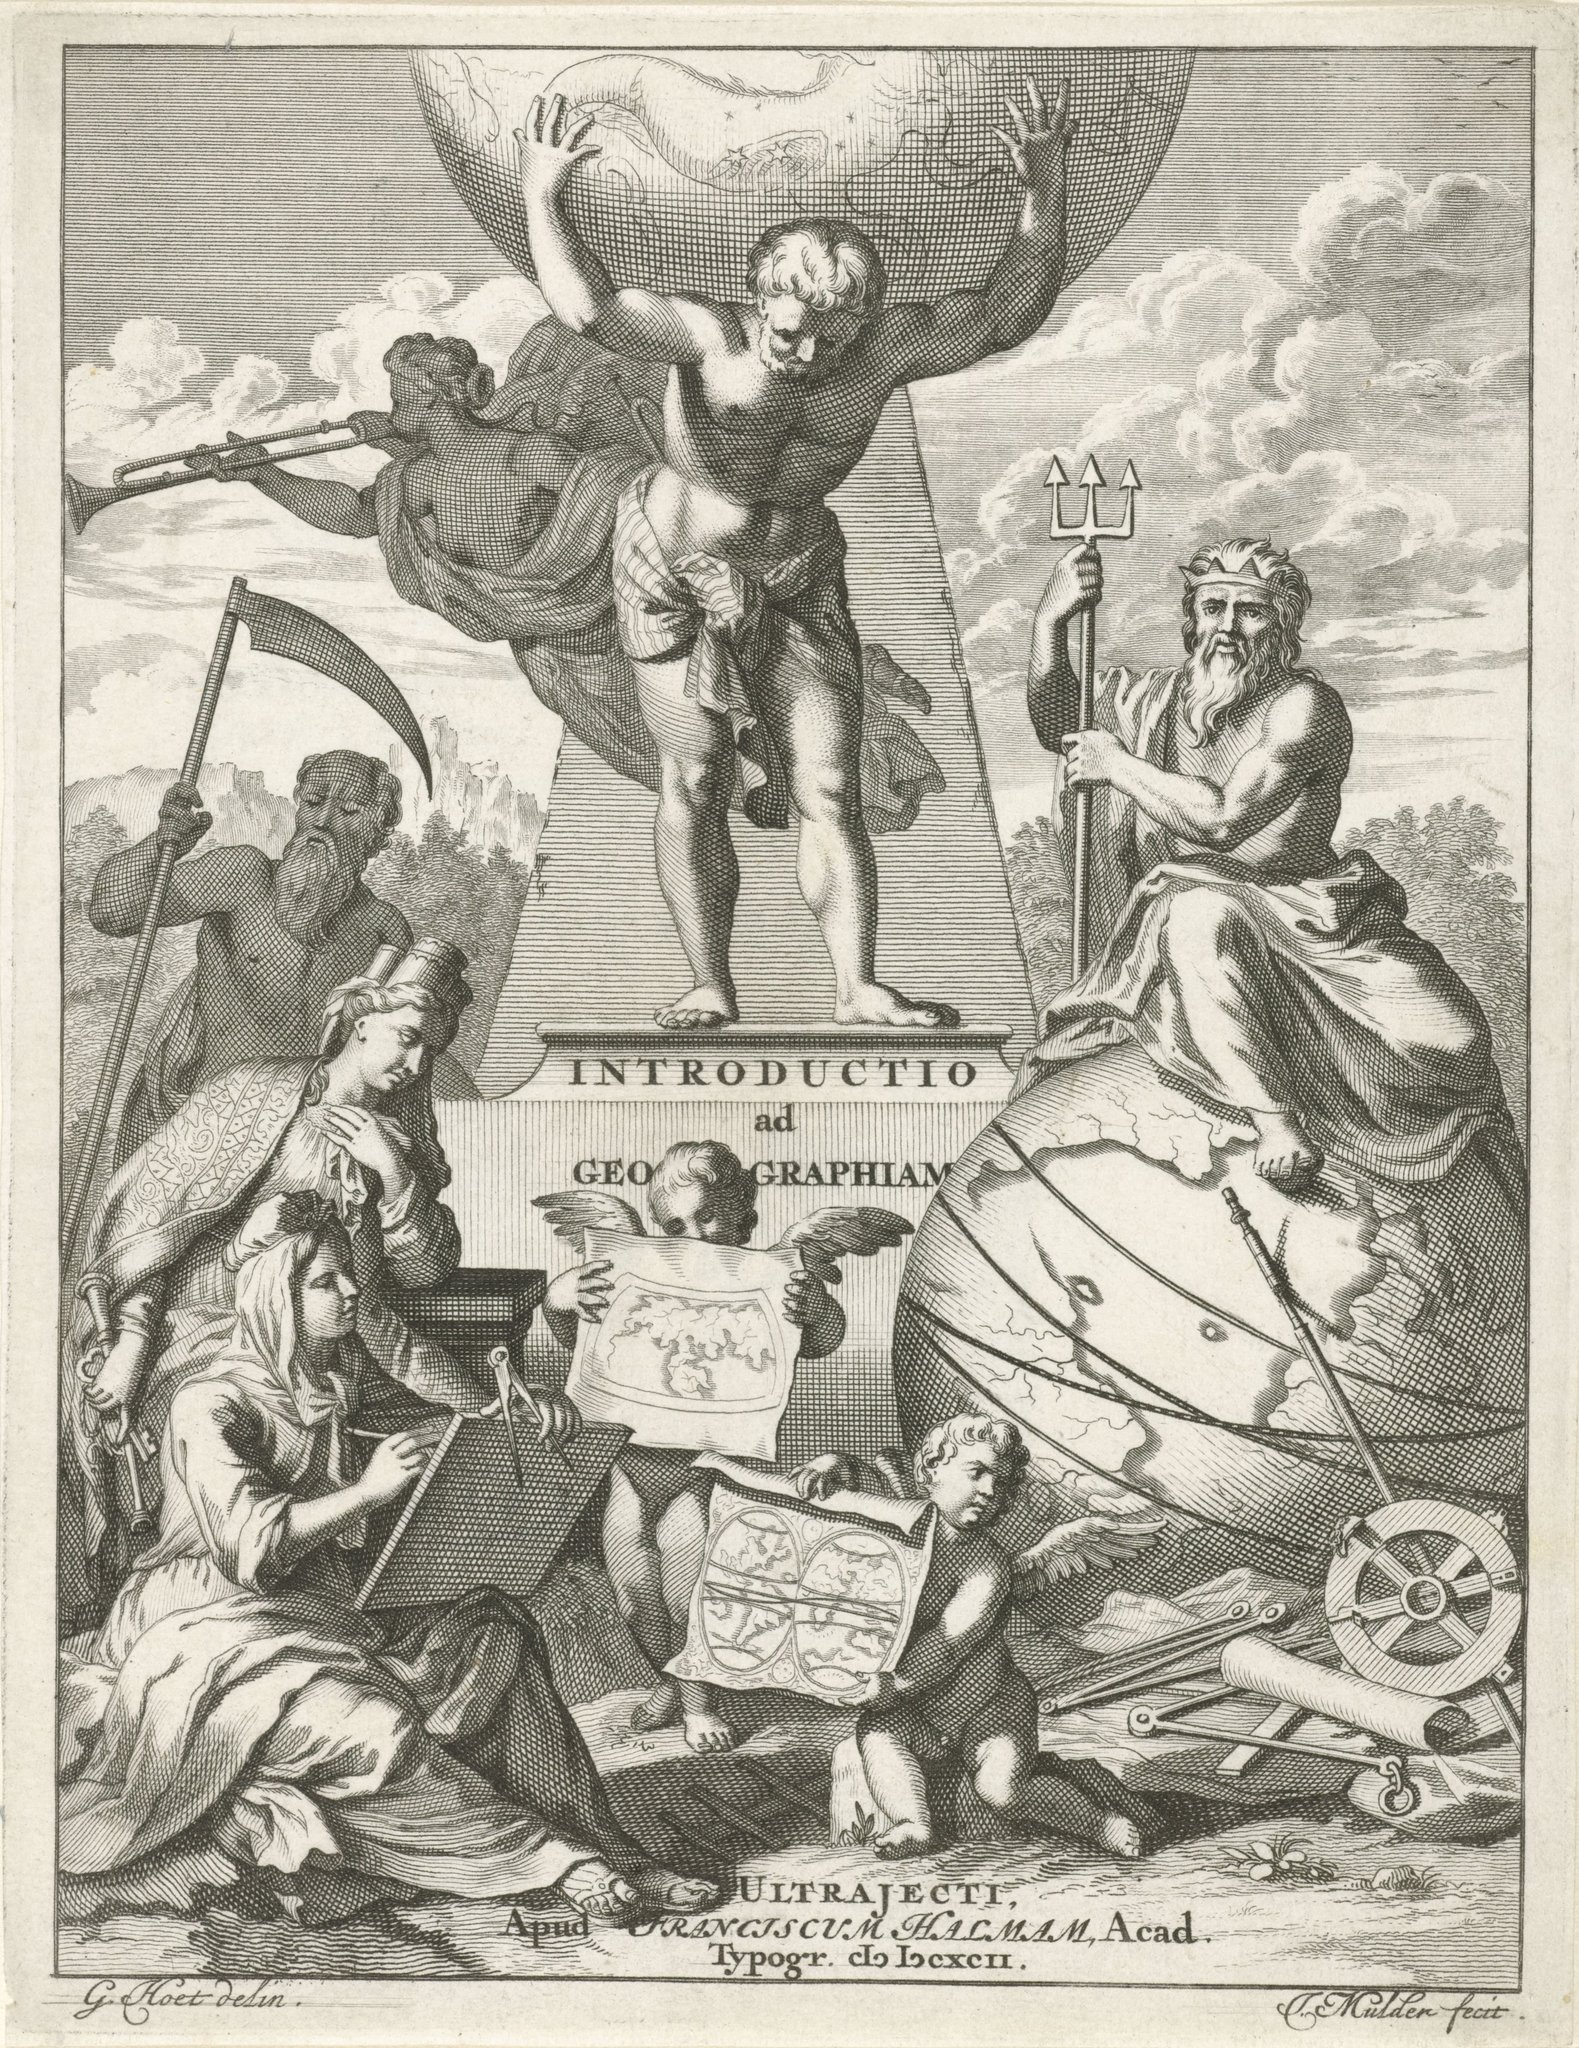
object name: print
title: Titelpagina voor: J. Luyts, Introductio ad geographiam novam et veterem, 1692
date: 1692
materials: paper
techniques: engraving, etching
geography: amsterdam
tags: (story of) neptune (poseidon), father time, man with wings and scythe (+ variant), (story of) cybele, rhea cybele, great mother of the gods (berecynt(h)ia), (story of) atlas, maps, atlases, compasses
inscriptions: collector's mark: Lugt 2228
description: In het midden torst Atlas de wereld op zijn schouders. Rechts zit Neptunus met de drietand op een globe. Links staat Vader Tijd. Voor hem staat Cybele, heerseres over de natuur, met de muurkroon op haar hoofd en een sleutel en scepter in haar hand. Zij kijkt over de schouder van een vrouw die tekent en een passer in haar hand houdt. Op de voorgrond tonen twee putti landkaarten. Titelpagina van een boek over landkaarten.